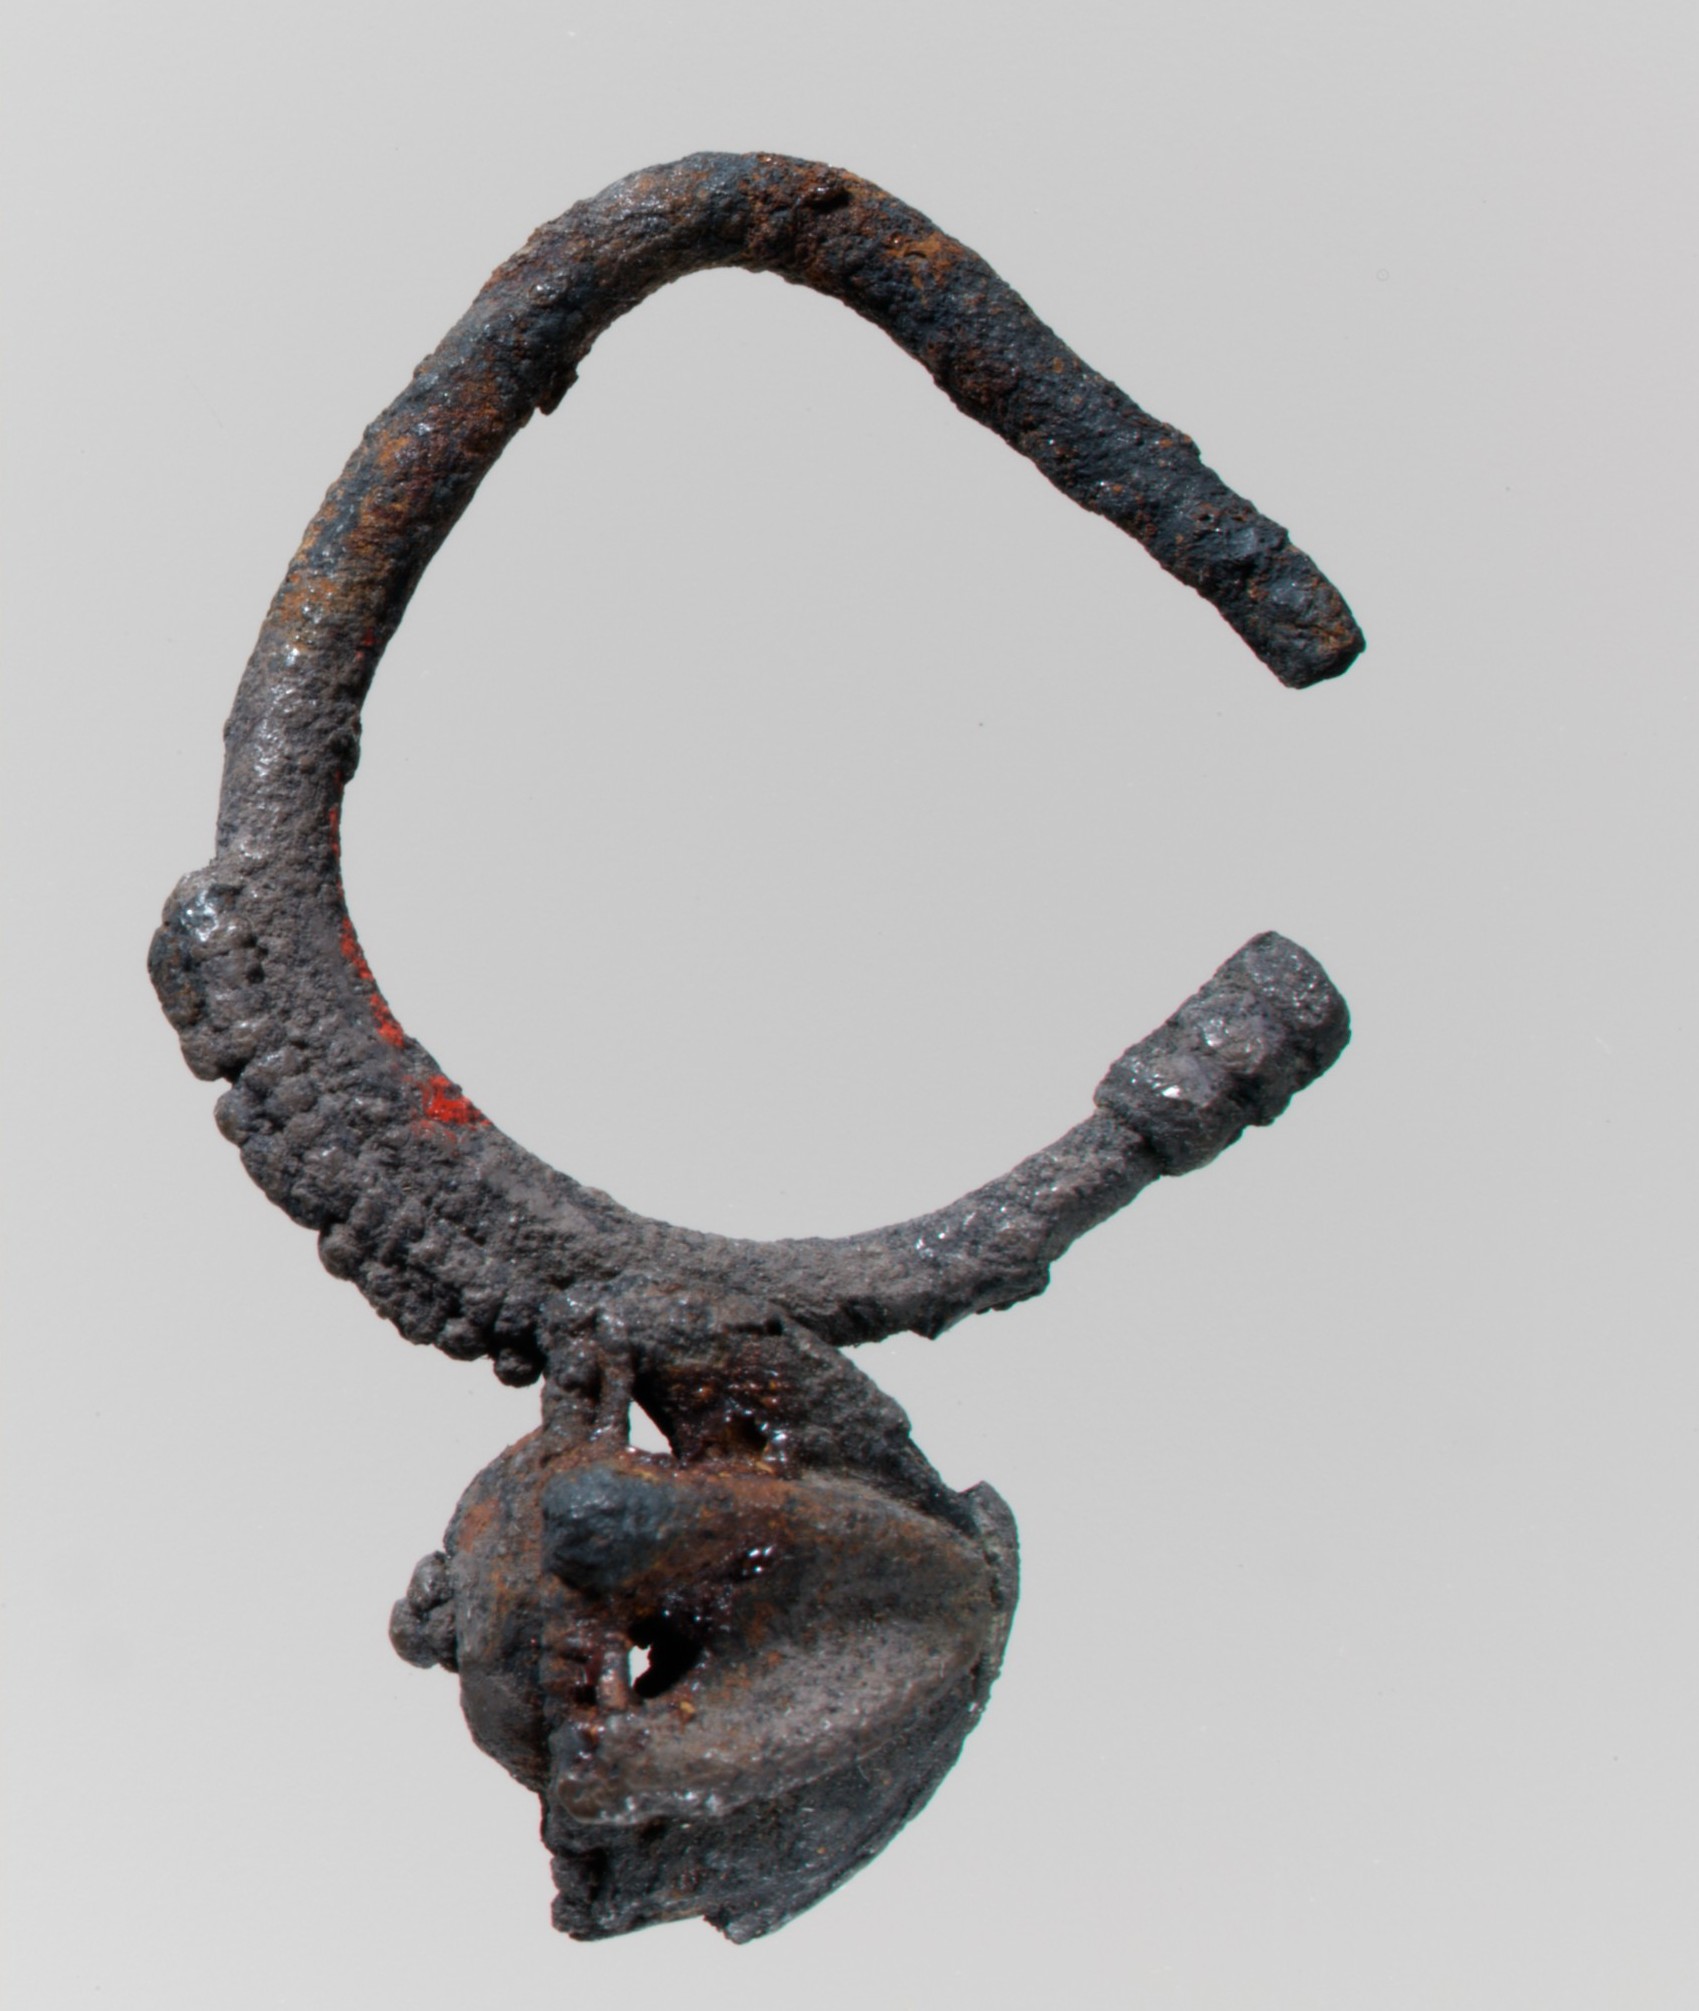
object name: earring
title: Earrings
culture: roman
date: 501-600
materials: silver, metal